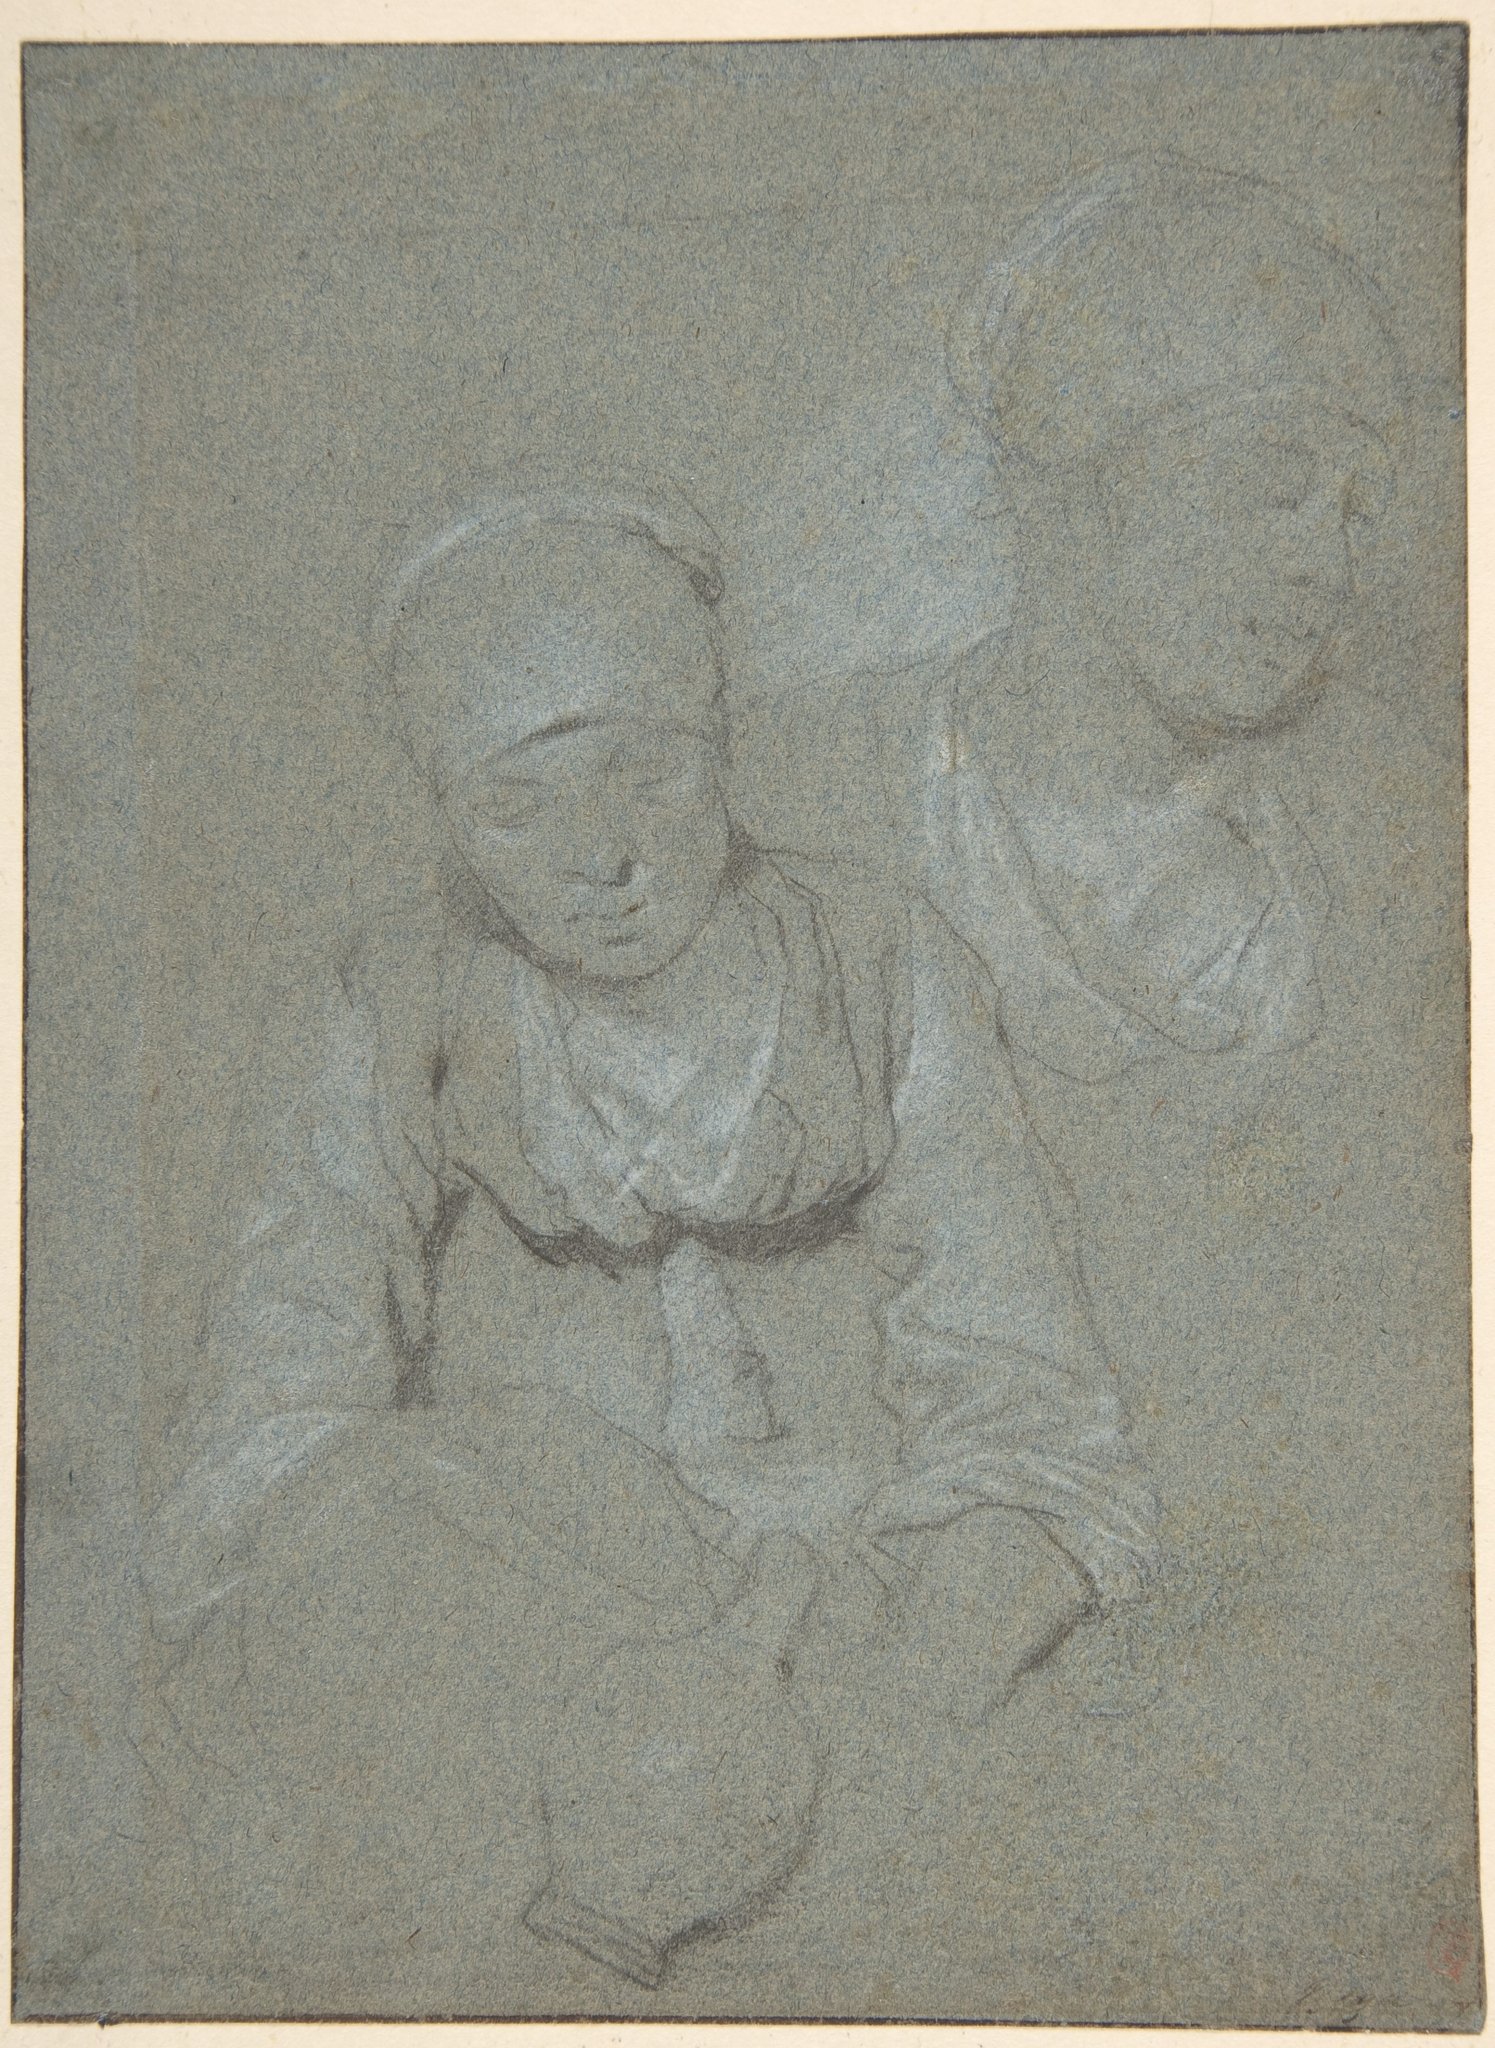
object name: drawing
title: Woman Holding a Jug and a Study of her Head Seen from the Left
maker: cornelis bega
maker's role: artist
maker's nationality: dutch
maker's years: 1631-1664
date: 1634-1666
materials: chalk, paper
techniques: heightening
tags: women,jugs